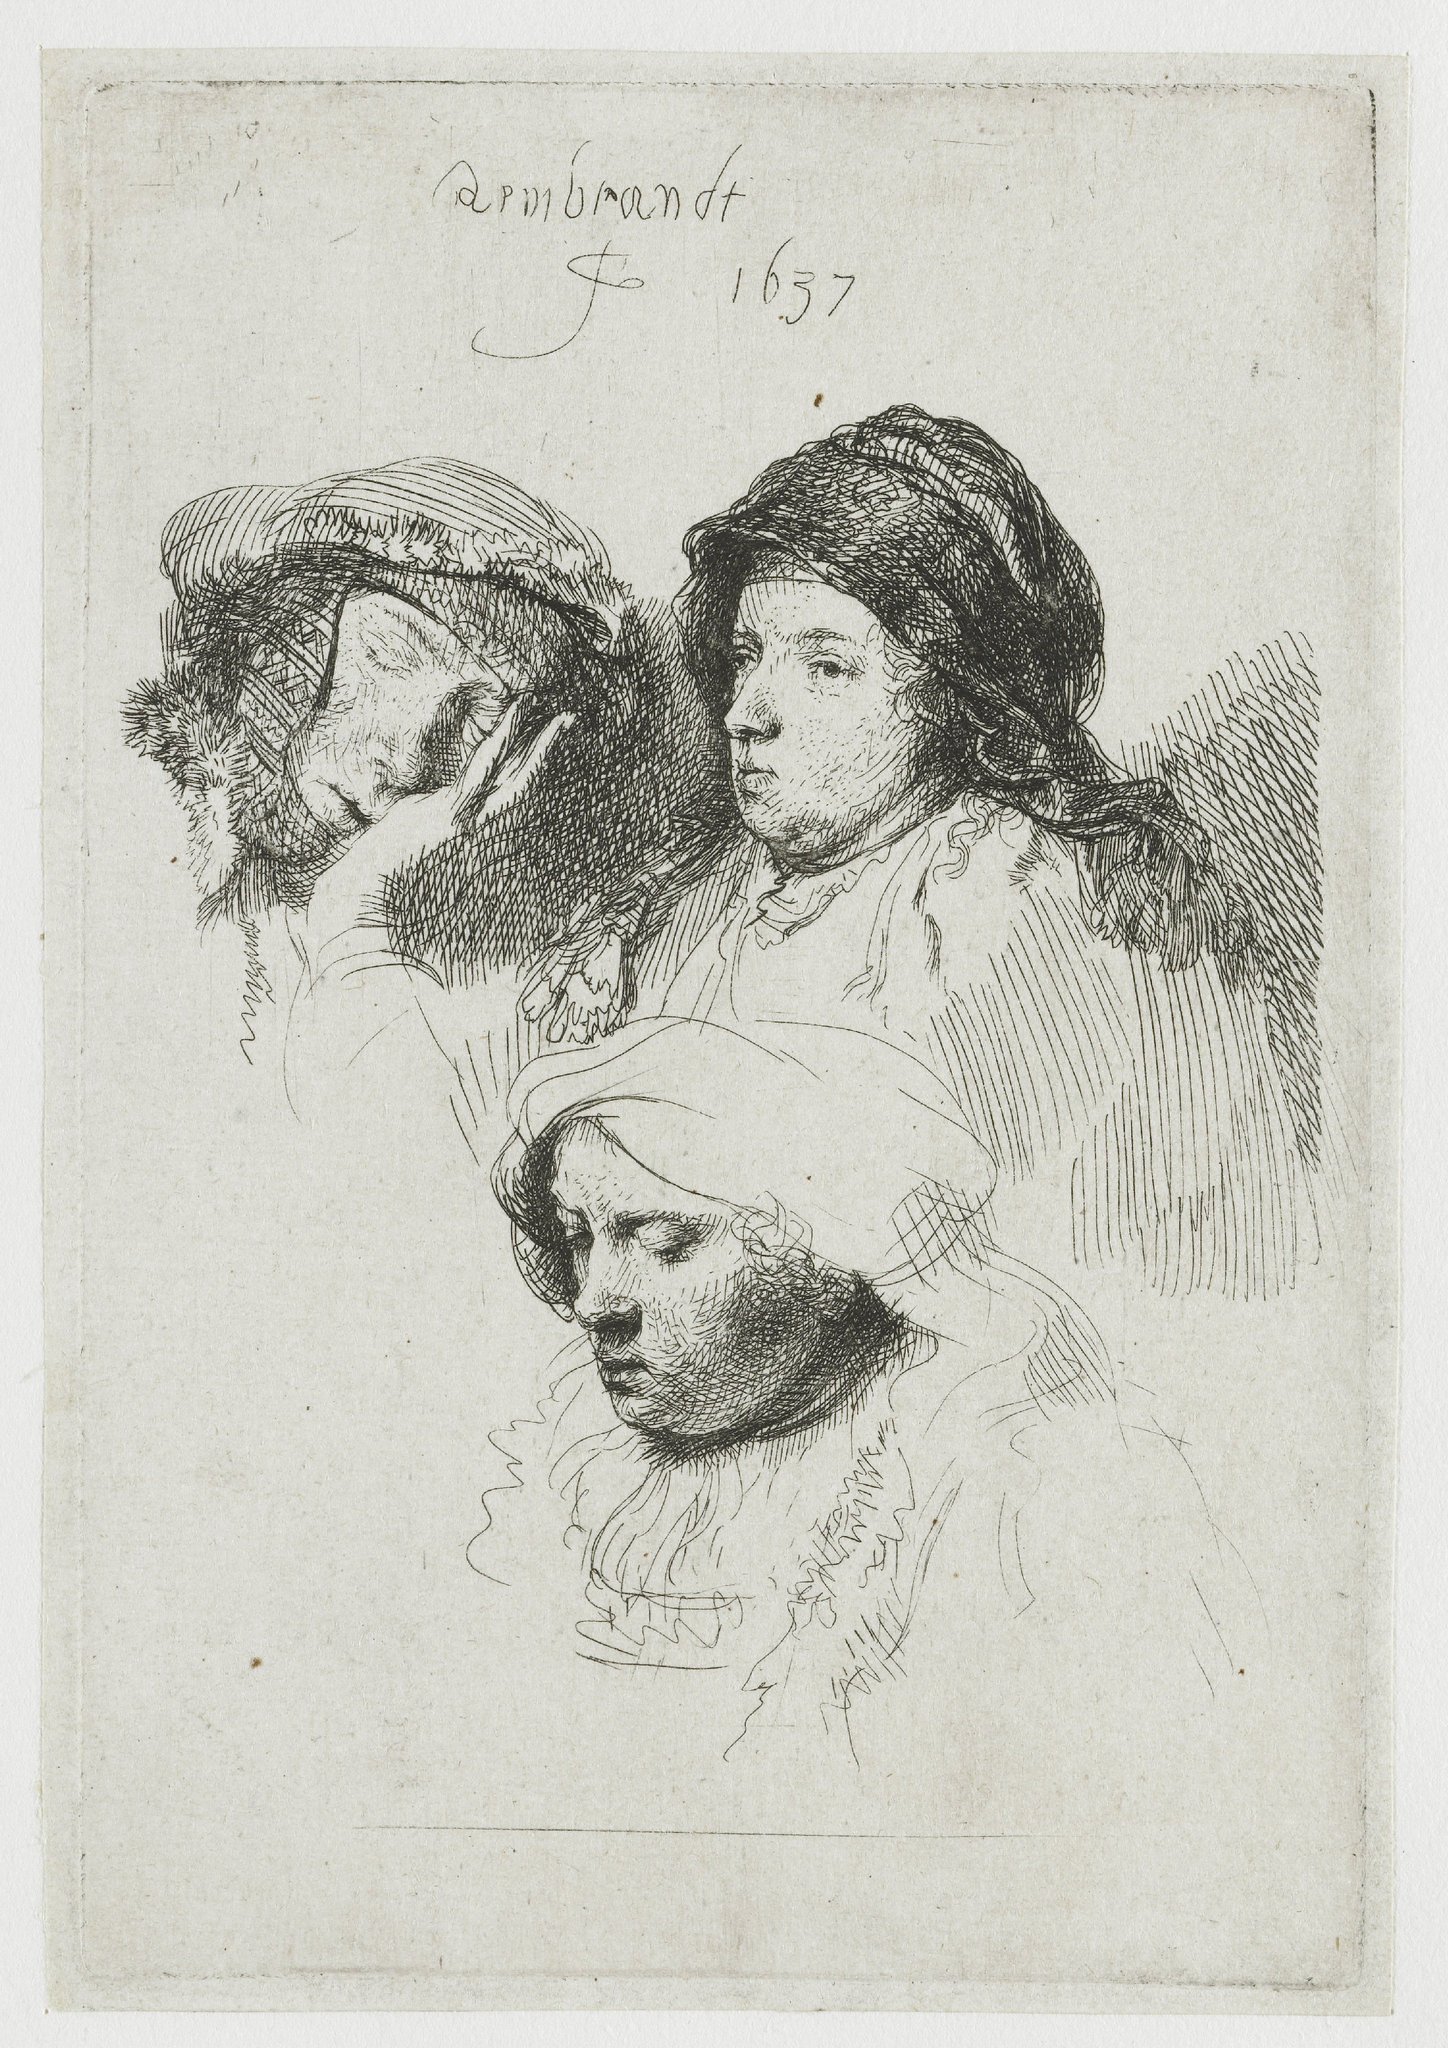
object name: print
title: Three heads of women: one asleep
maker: rembrandt van rijn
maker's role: draughtsman, painter, print maker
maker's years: 1606-1669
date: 1637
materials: paper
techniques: etching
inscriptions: signature and date: ‘Rembrandt f 1637’, mark: Lugt 402, mark: Lugt 2228, mark: Lugt 65